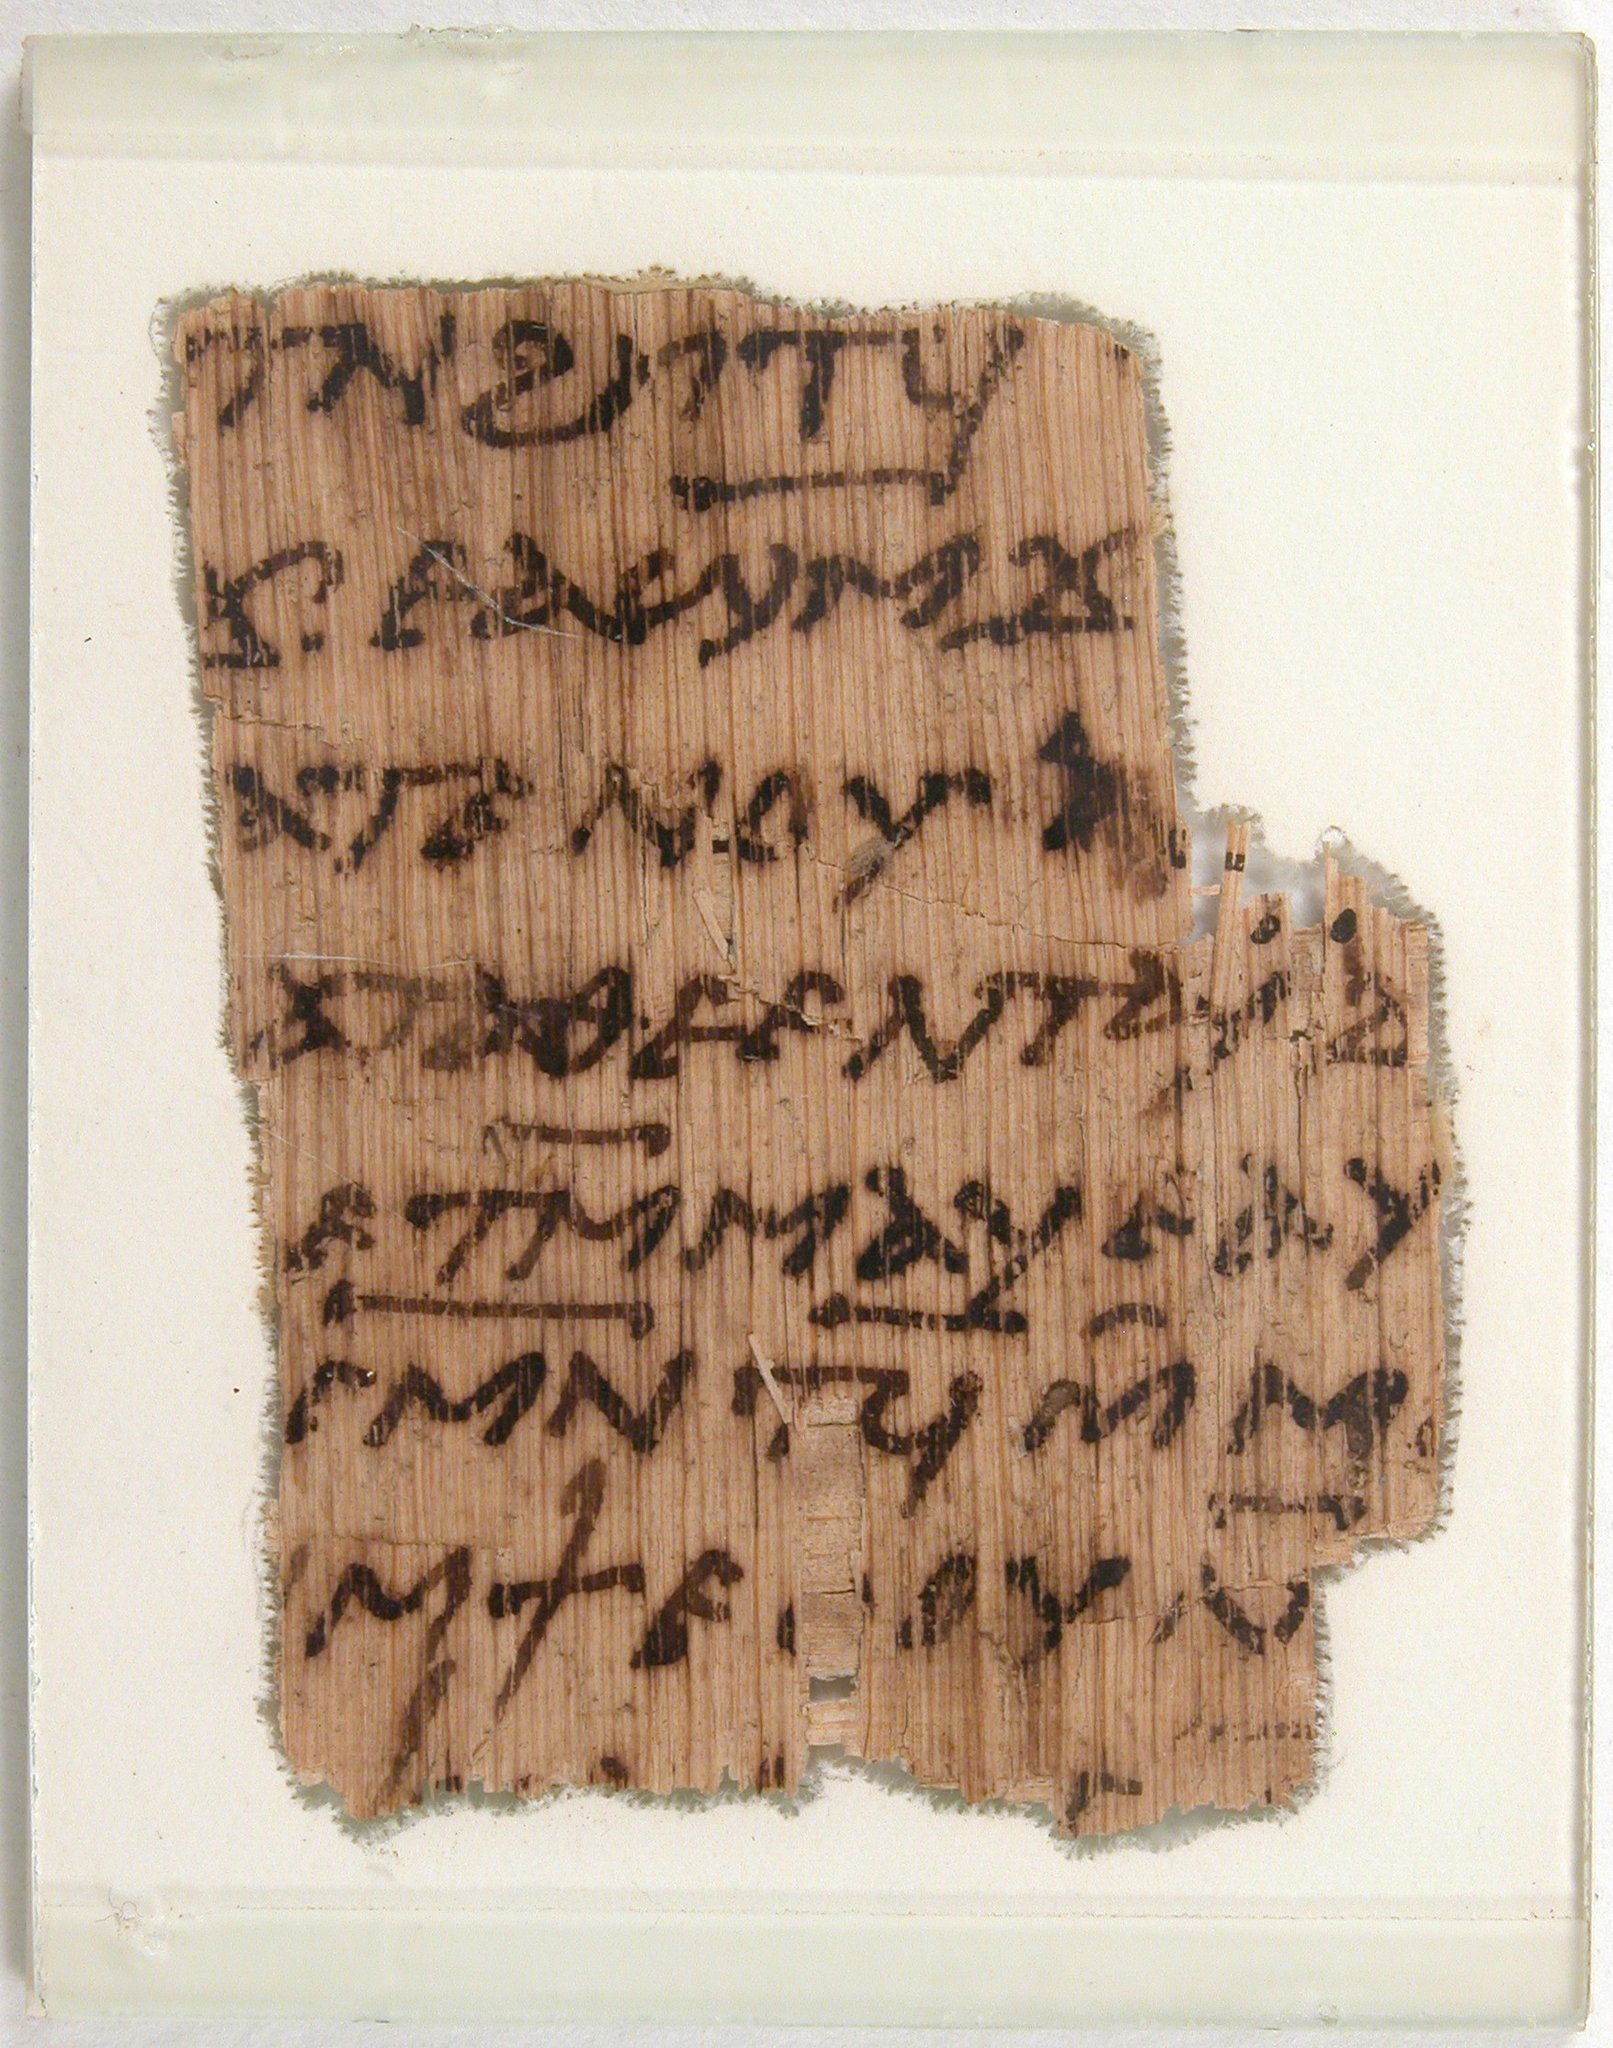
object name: papyrus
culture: coptic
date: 601-700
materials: ink, papyrus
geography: egypt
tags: documents